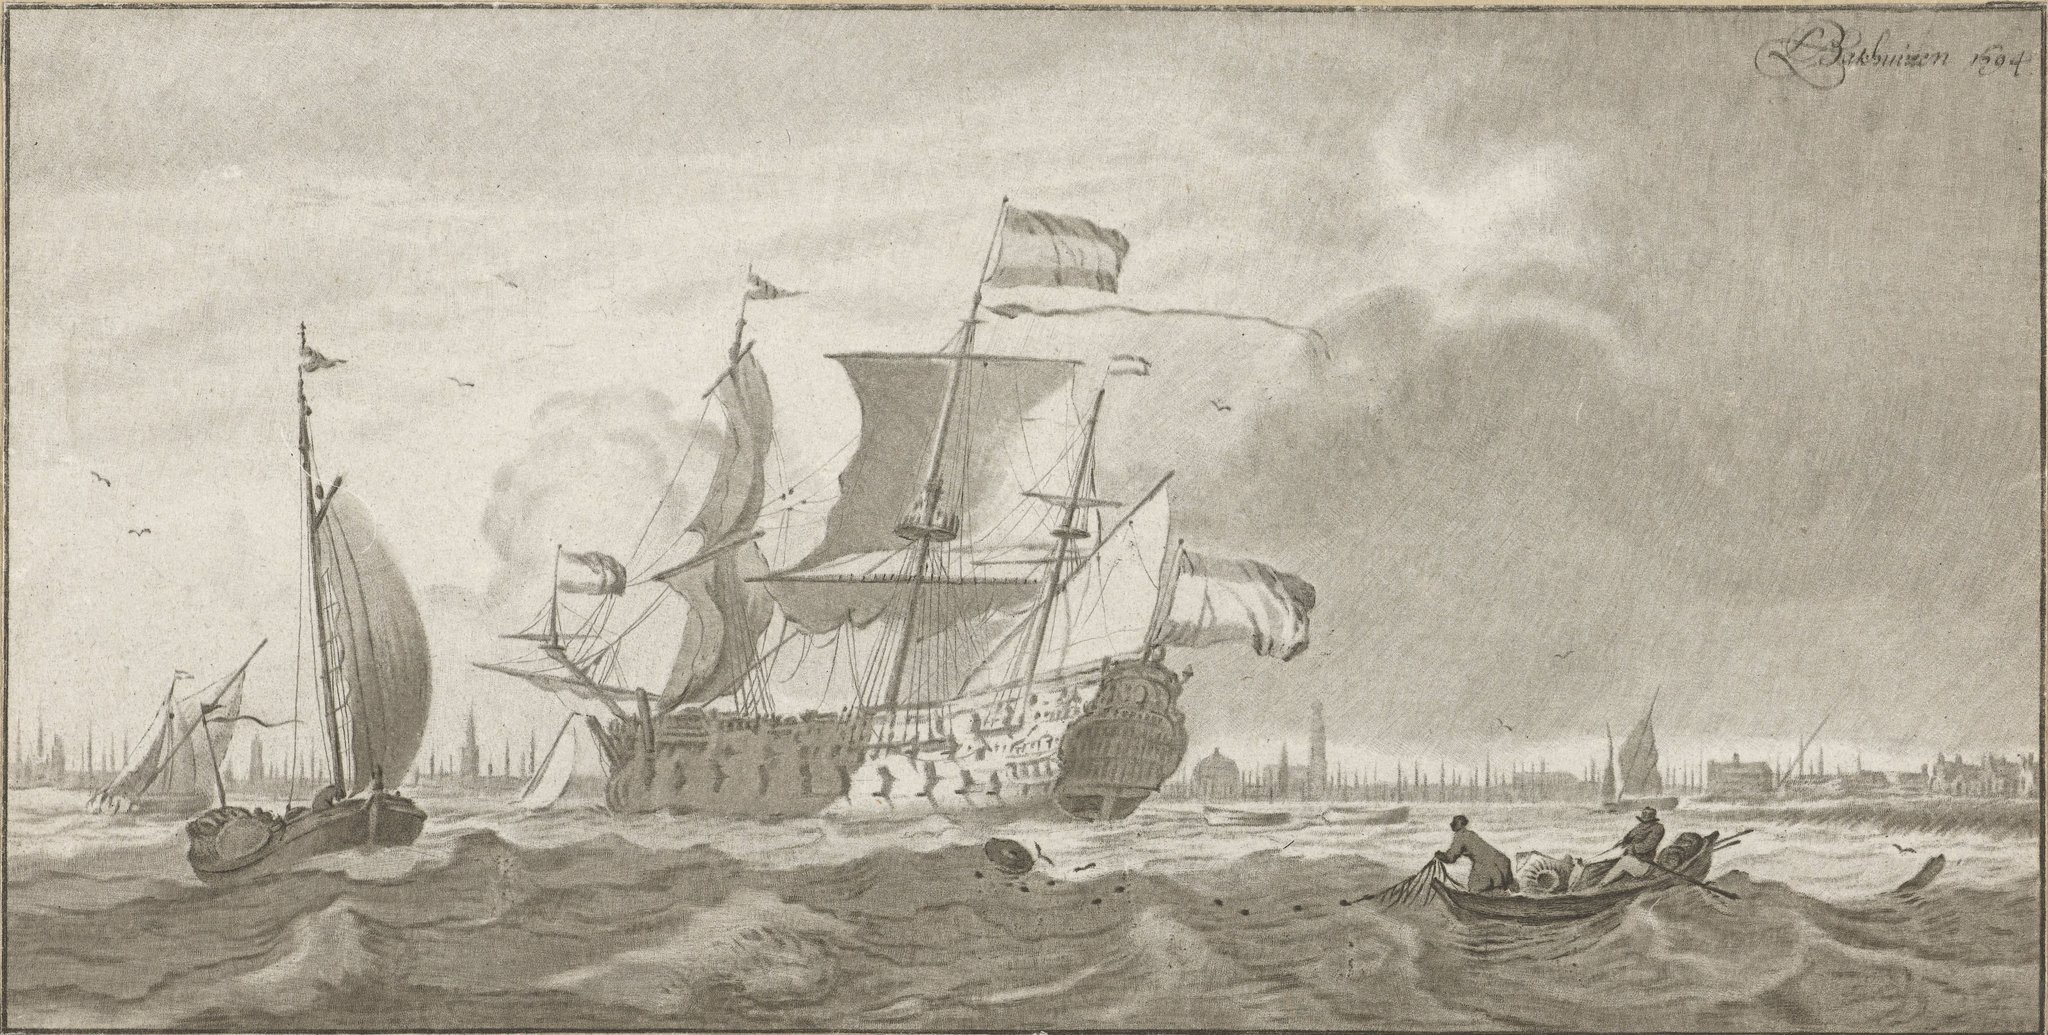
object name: print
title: Oorlogsschip op het IJ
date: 1768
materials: paper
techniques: etching, roulette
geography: amsterdam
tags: sailing-ship, sailing-boat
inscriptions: collector's mark: Lugt 12, collector's mark: Lugt 2725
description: Een oorlogsschip op het IJ voor Amsterdam. Links een zeil schip, rechts een roeiboot met vissers.